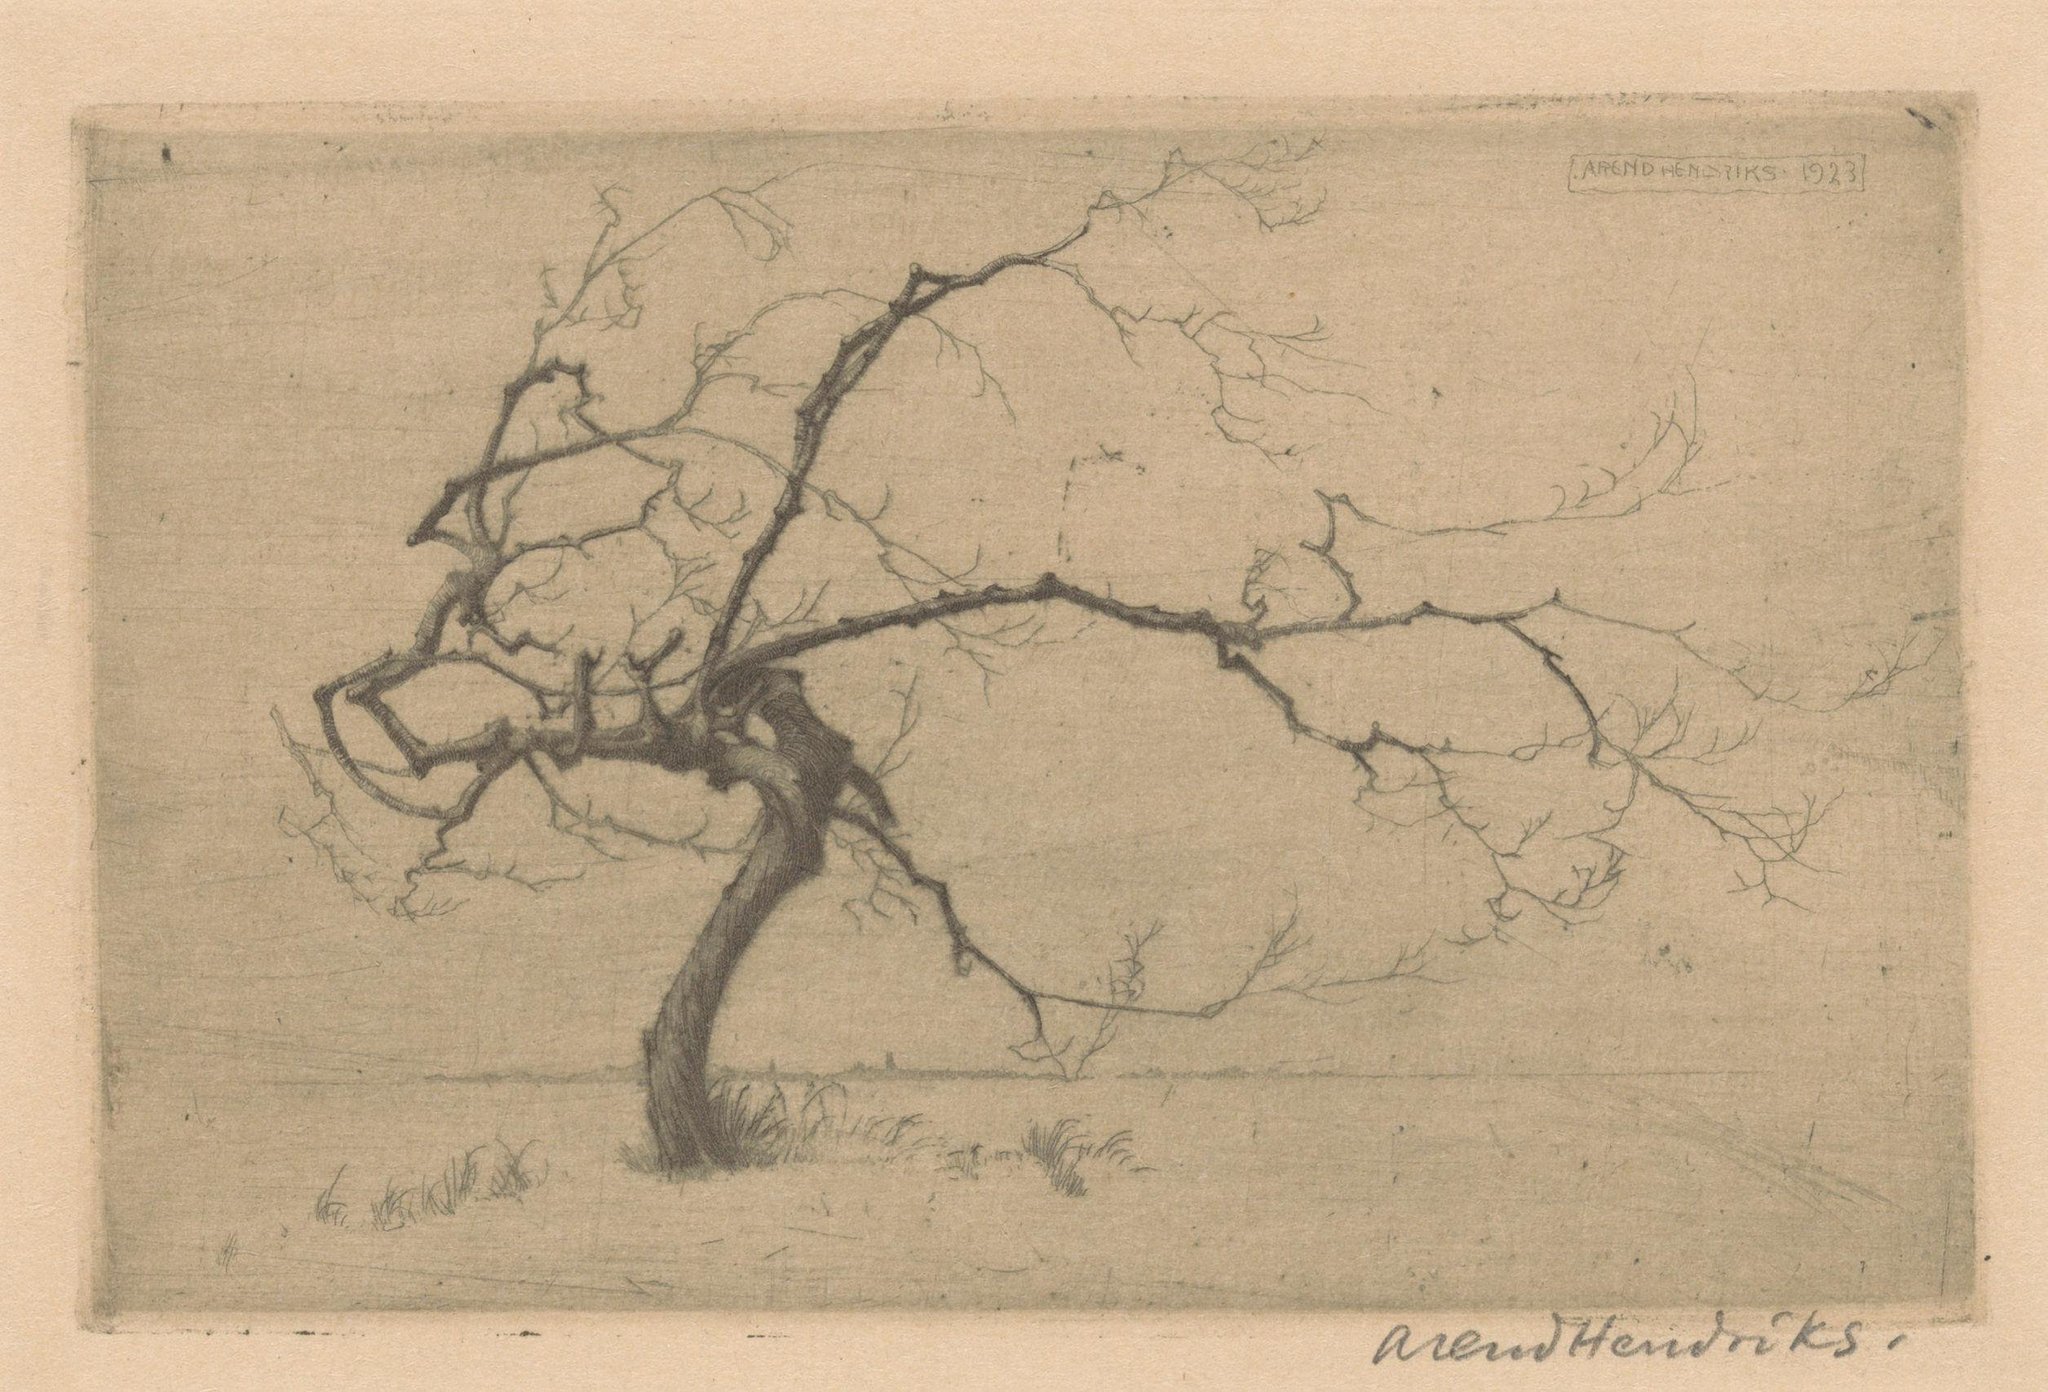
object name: print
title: Klein boompje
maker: arend hendriks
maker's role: print maker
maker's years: 1901-1951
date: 1923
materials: paper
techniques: etching, intaglio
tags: trees (+ bare plant)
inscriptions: collector's mark: Lugt 2228, collector's mark: Lugt 2760